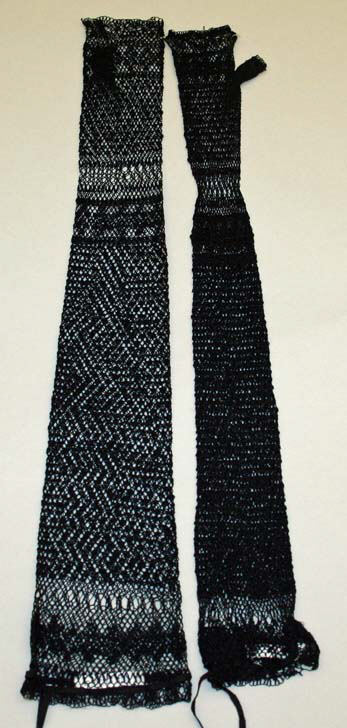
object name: mitt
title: Mitts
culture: american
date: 1870-1879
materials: silk